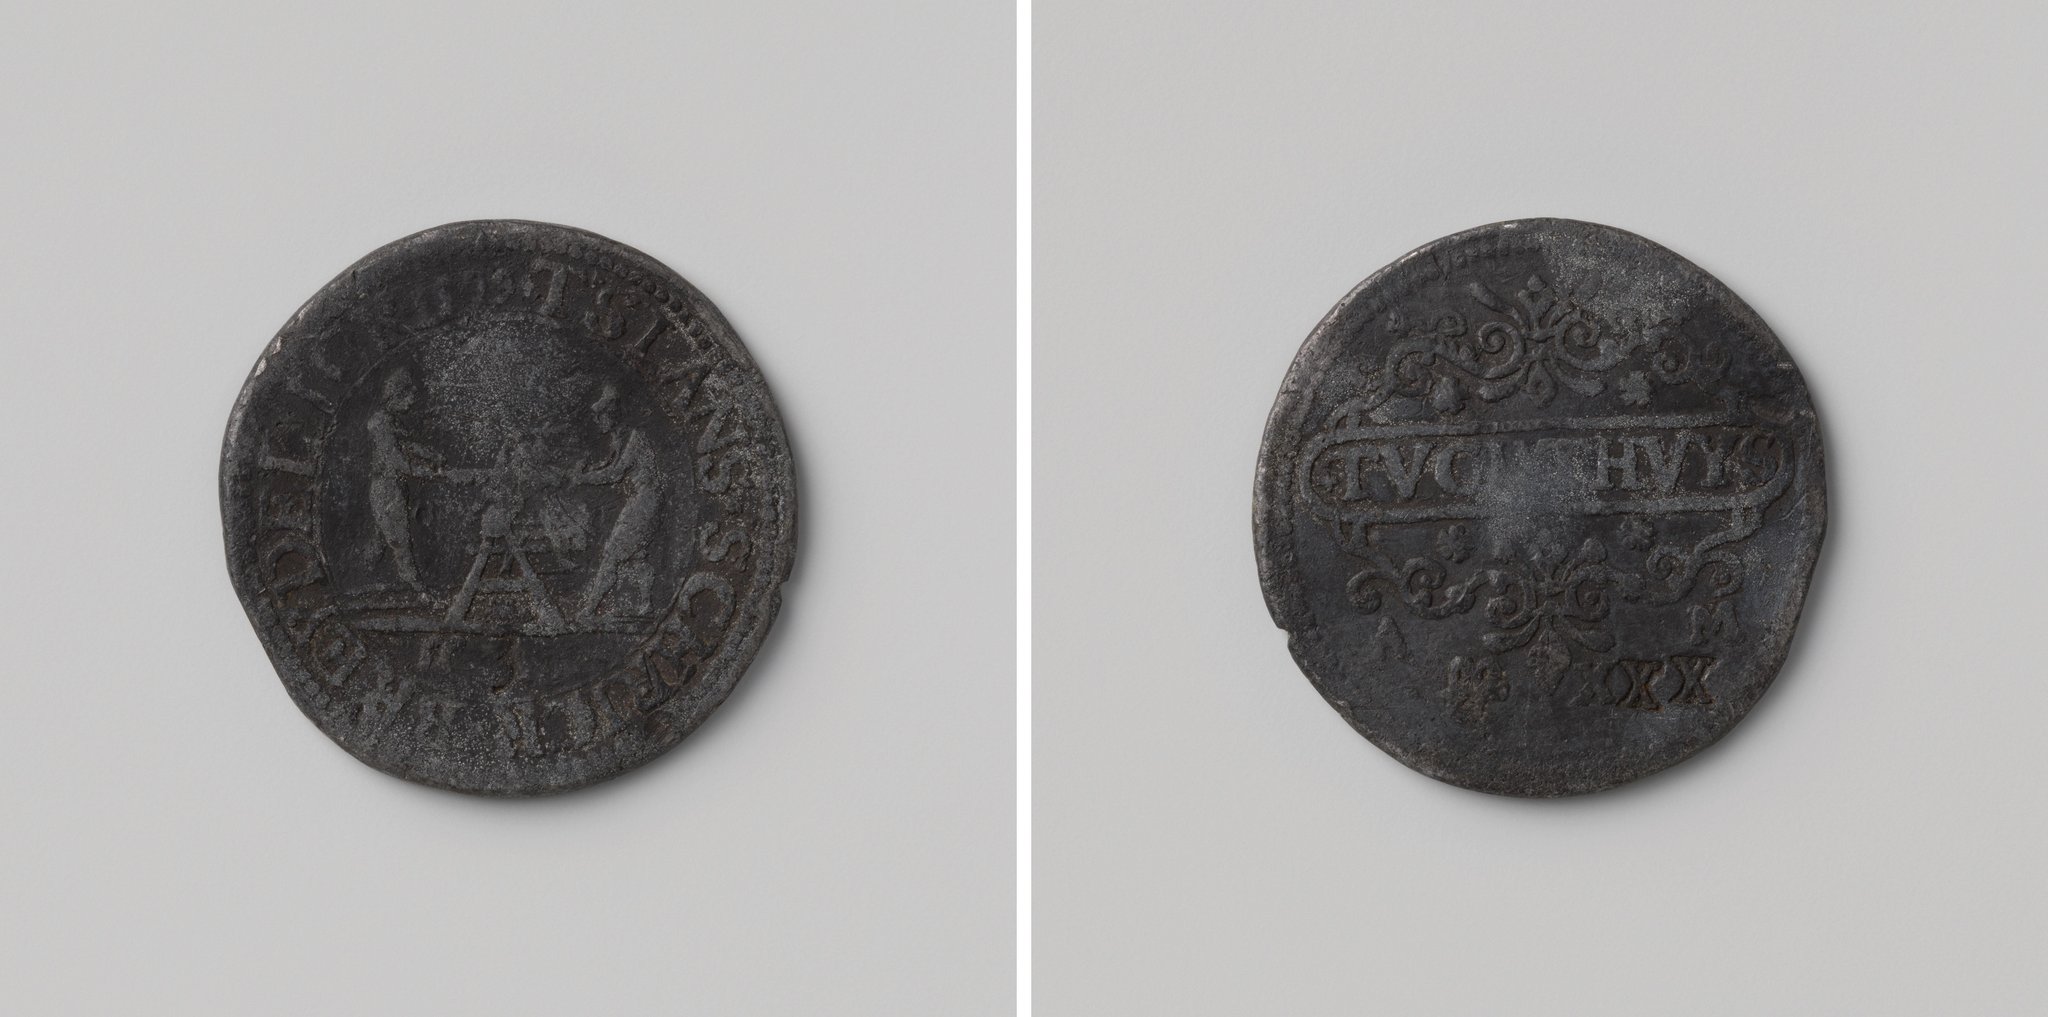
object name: monetary token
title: Tuchthuis te Amsterdam (rasphuis), huismunt met no. 3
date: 1599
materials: lead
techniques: striking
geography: amsterdam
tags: amsterdam